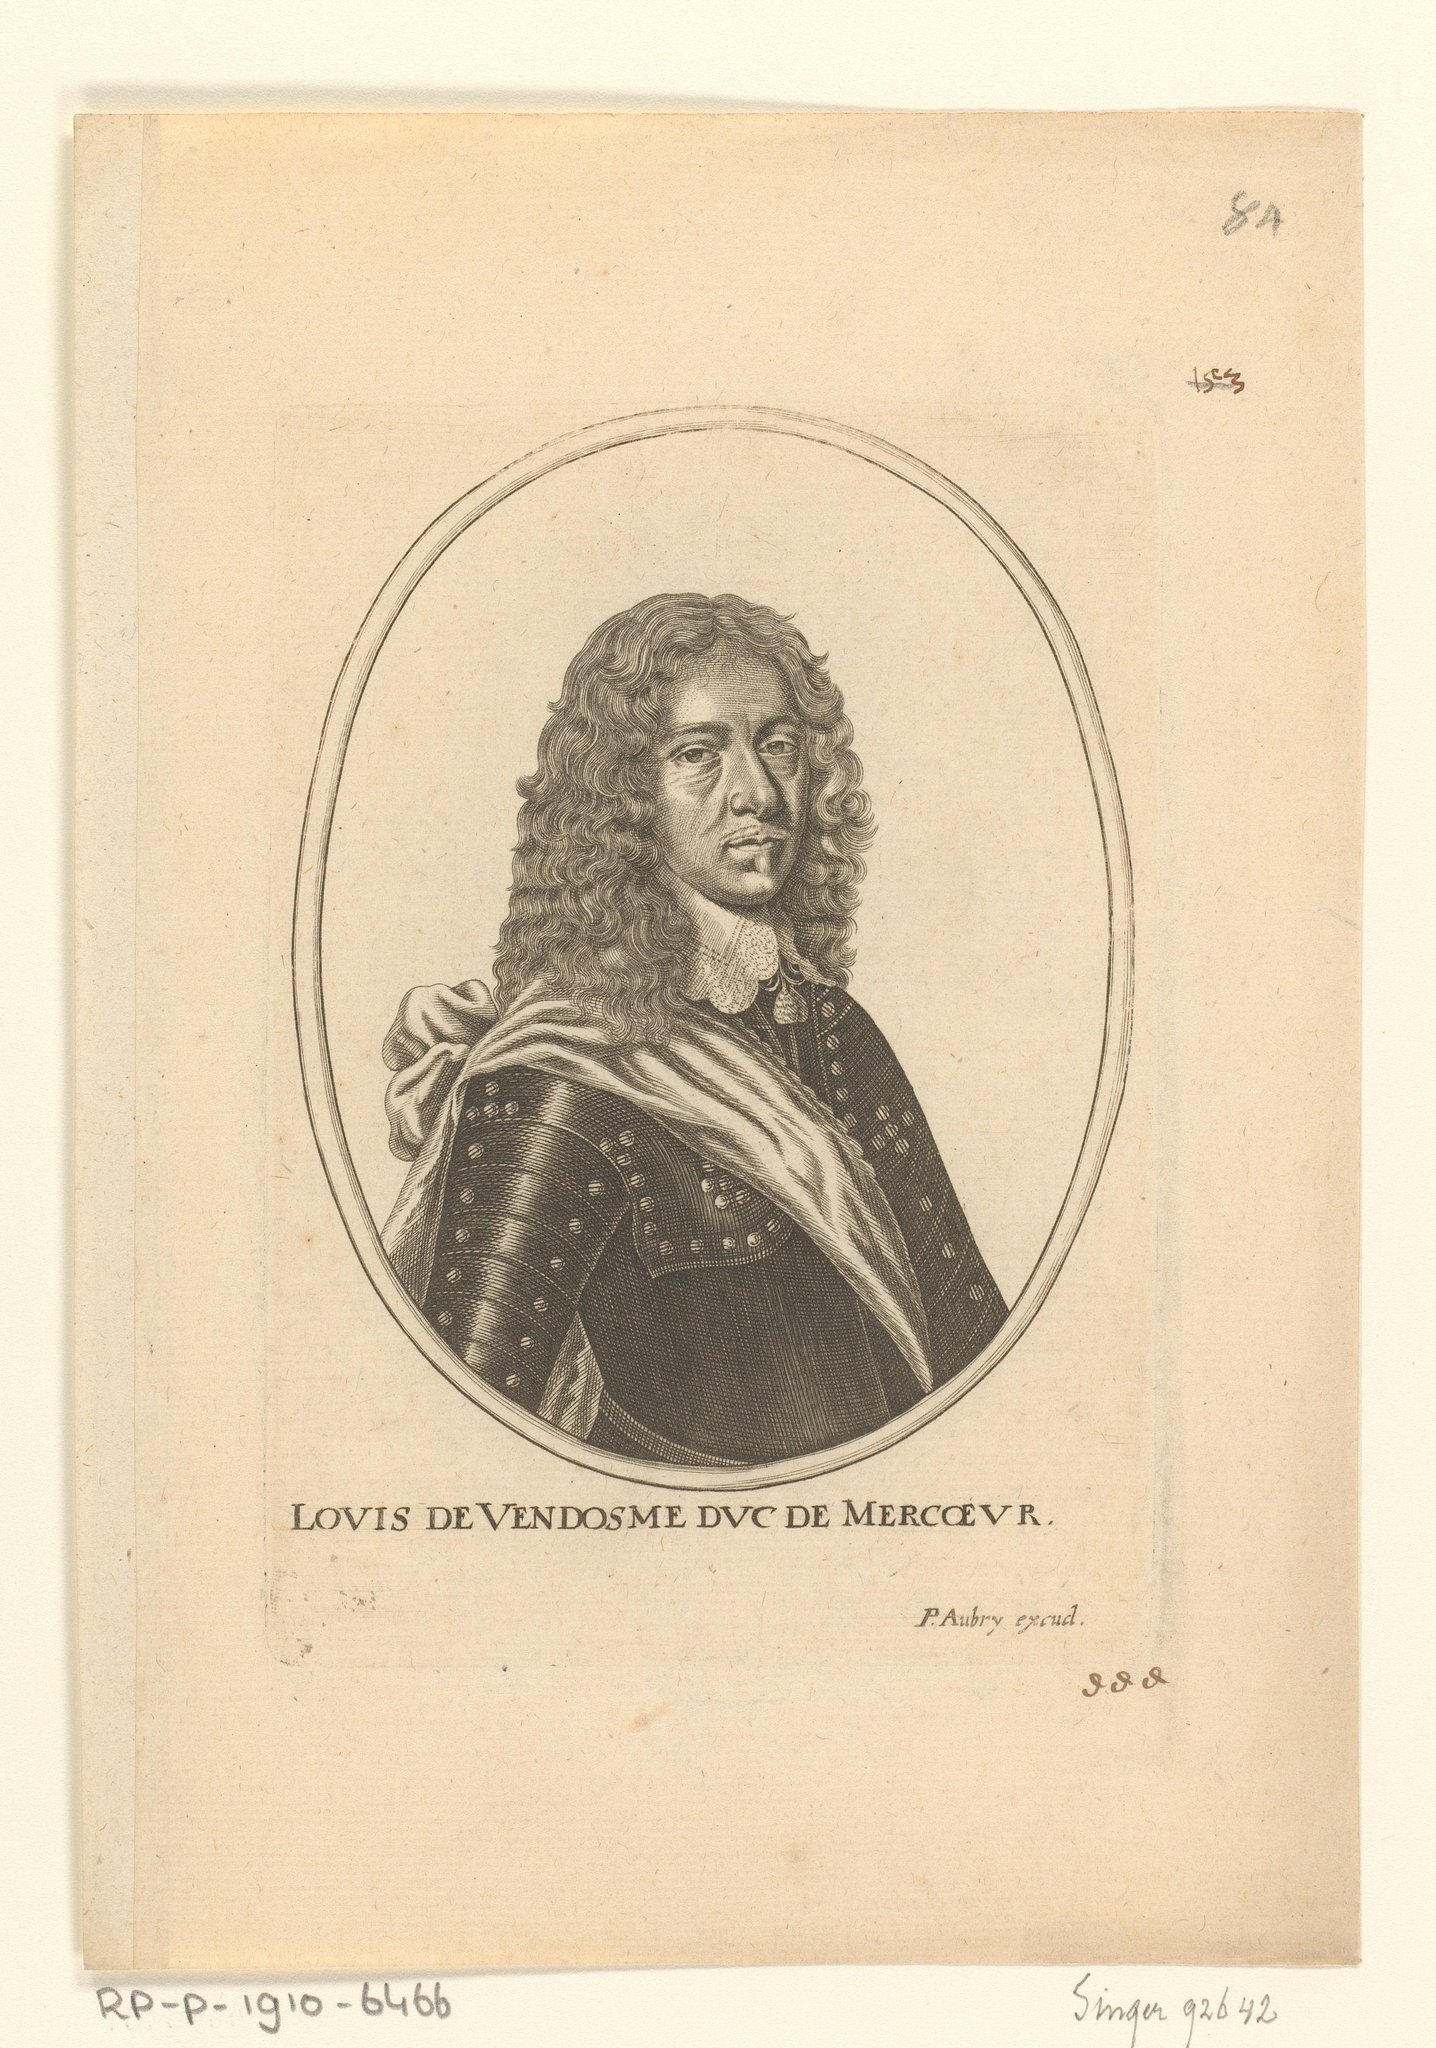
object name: print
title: Portret van Lodewijk II van Vendôme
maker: Anonymous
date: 1649-1686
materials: paper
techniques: engraving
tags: paris, historical persons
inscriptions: collector's mark: Lugt 2228, number: ‘153’, inscription: ‘ddd (?)’